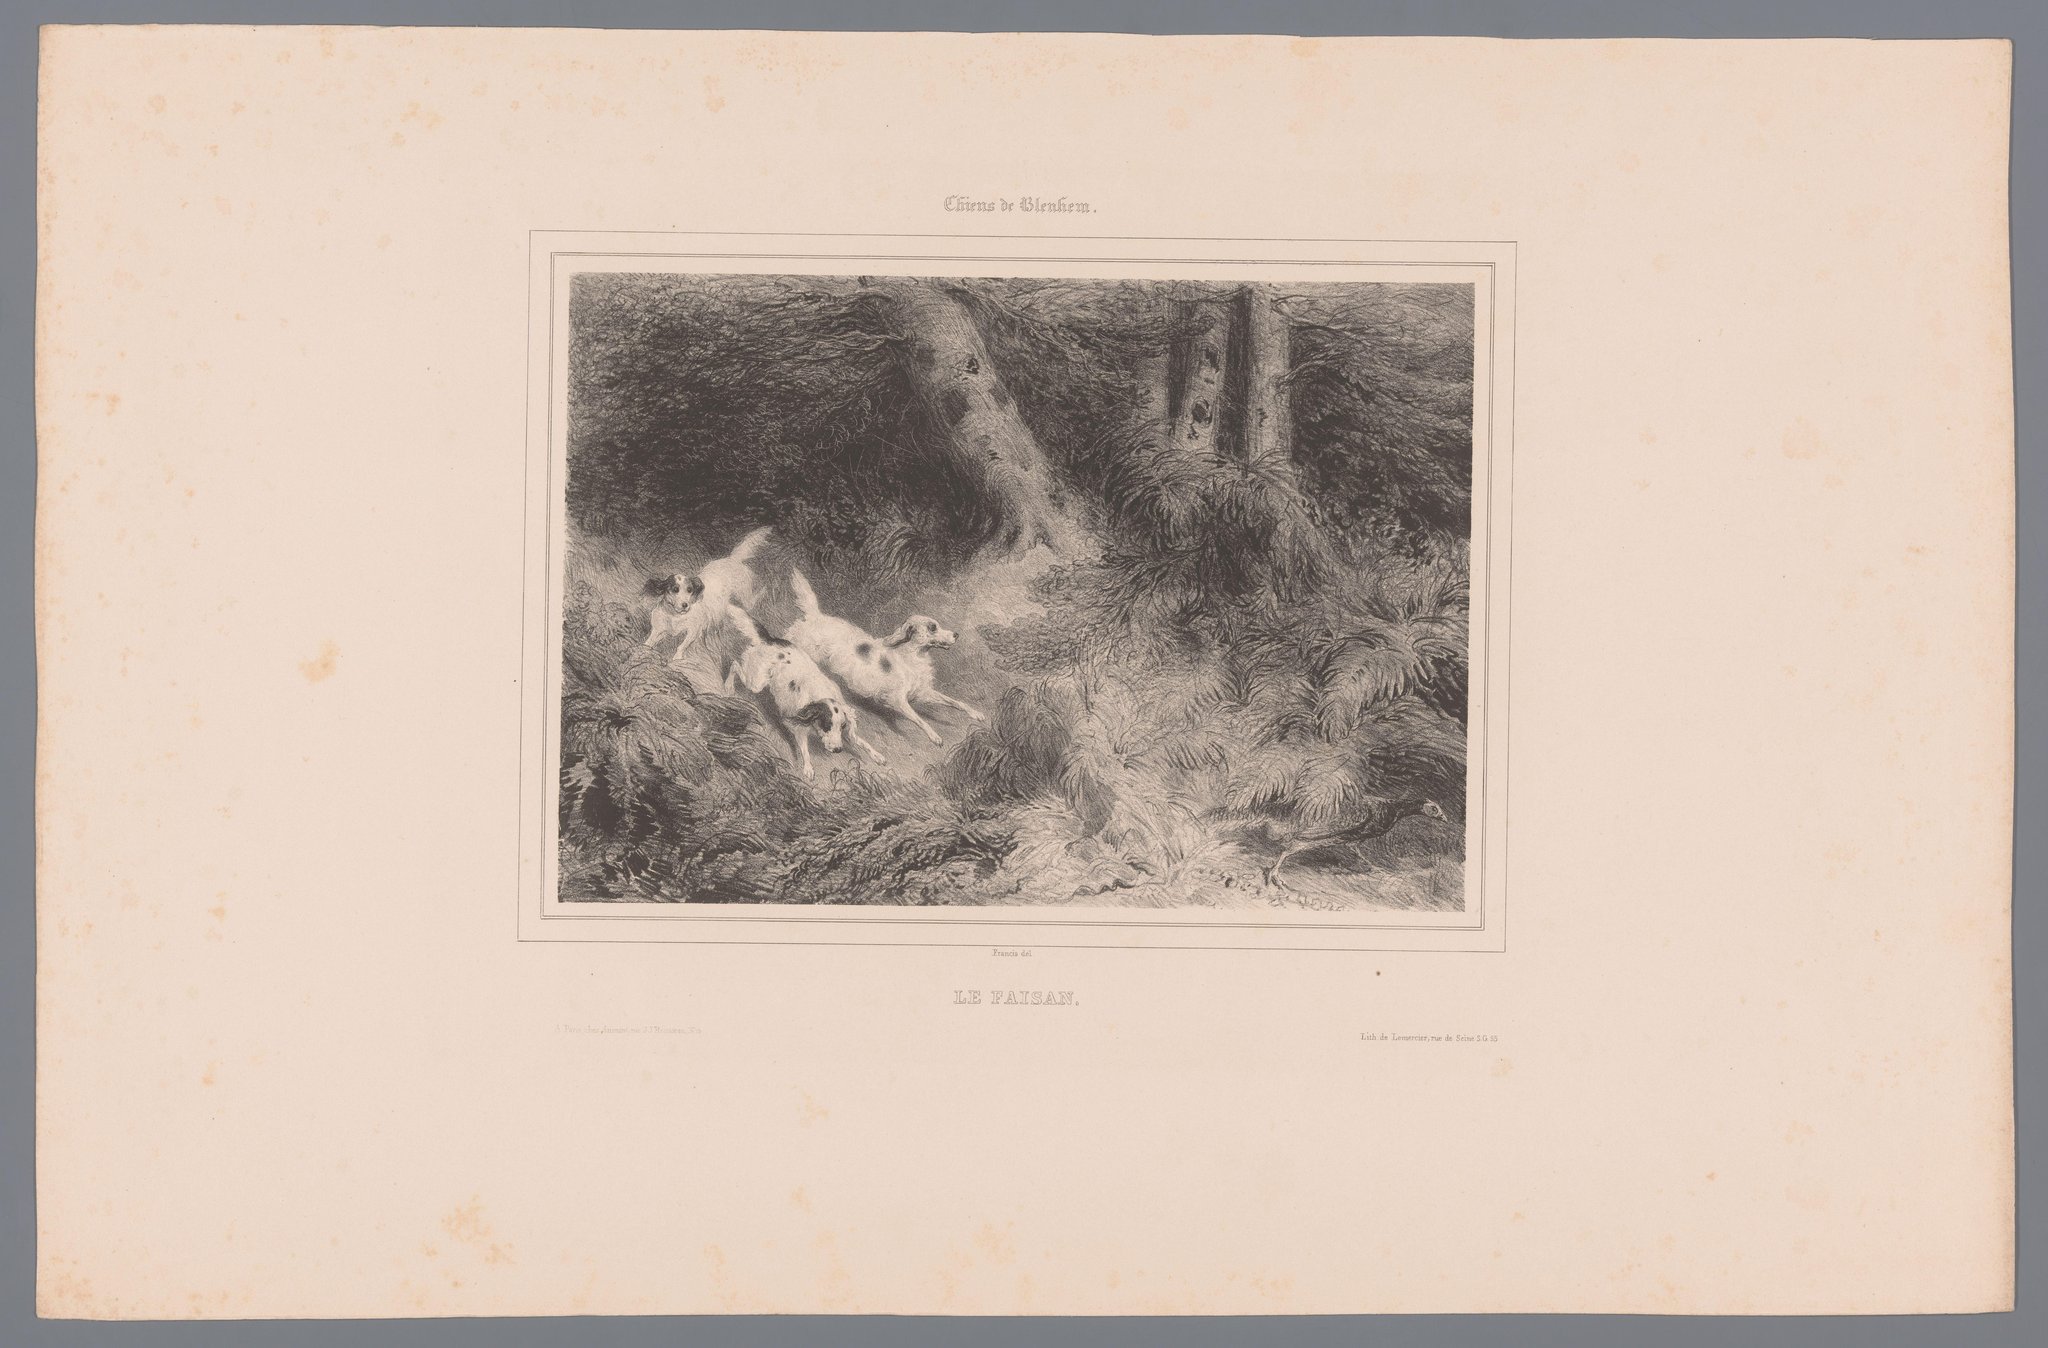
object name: print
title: Suite de Chiens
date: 1837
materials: paper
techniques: lithograph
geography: paris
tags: hunting dogs, walker and runner birds: pheasant, bird hunting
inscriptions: collector's mark: Lugt 2228a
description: Prent maakt deel uit van een omslag met zes prenten.